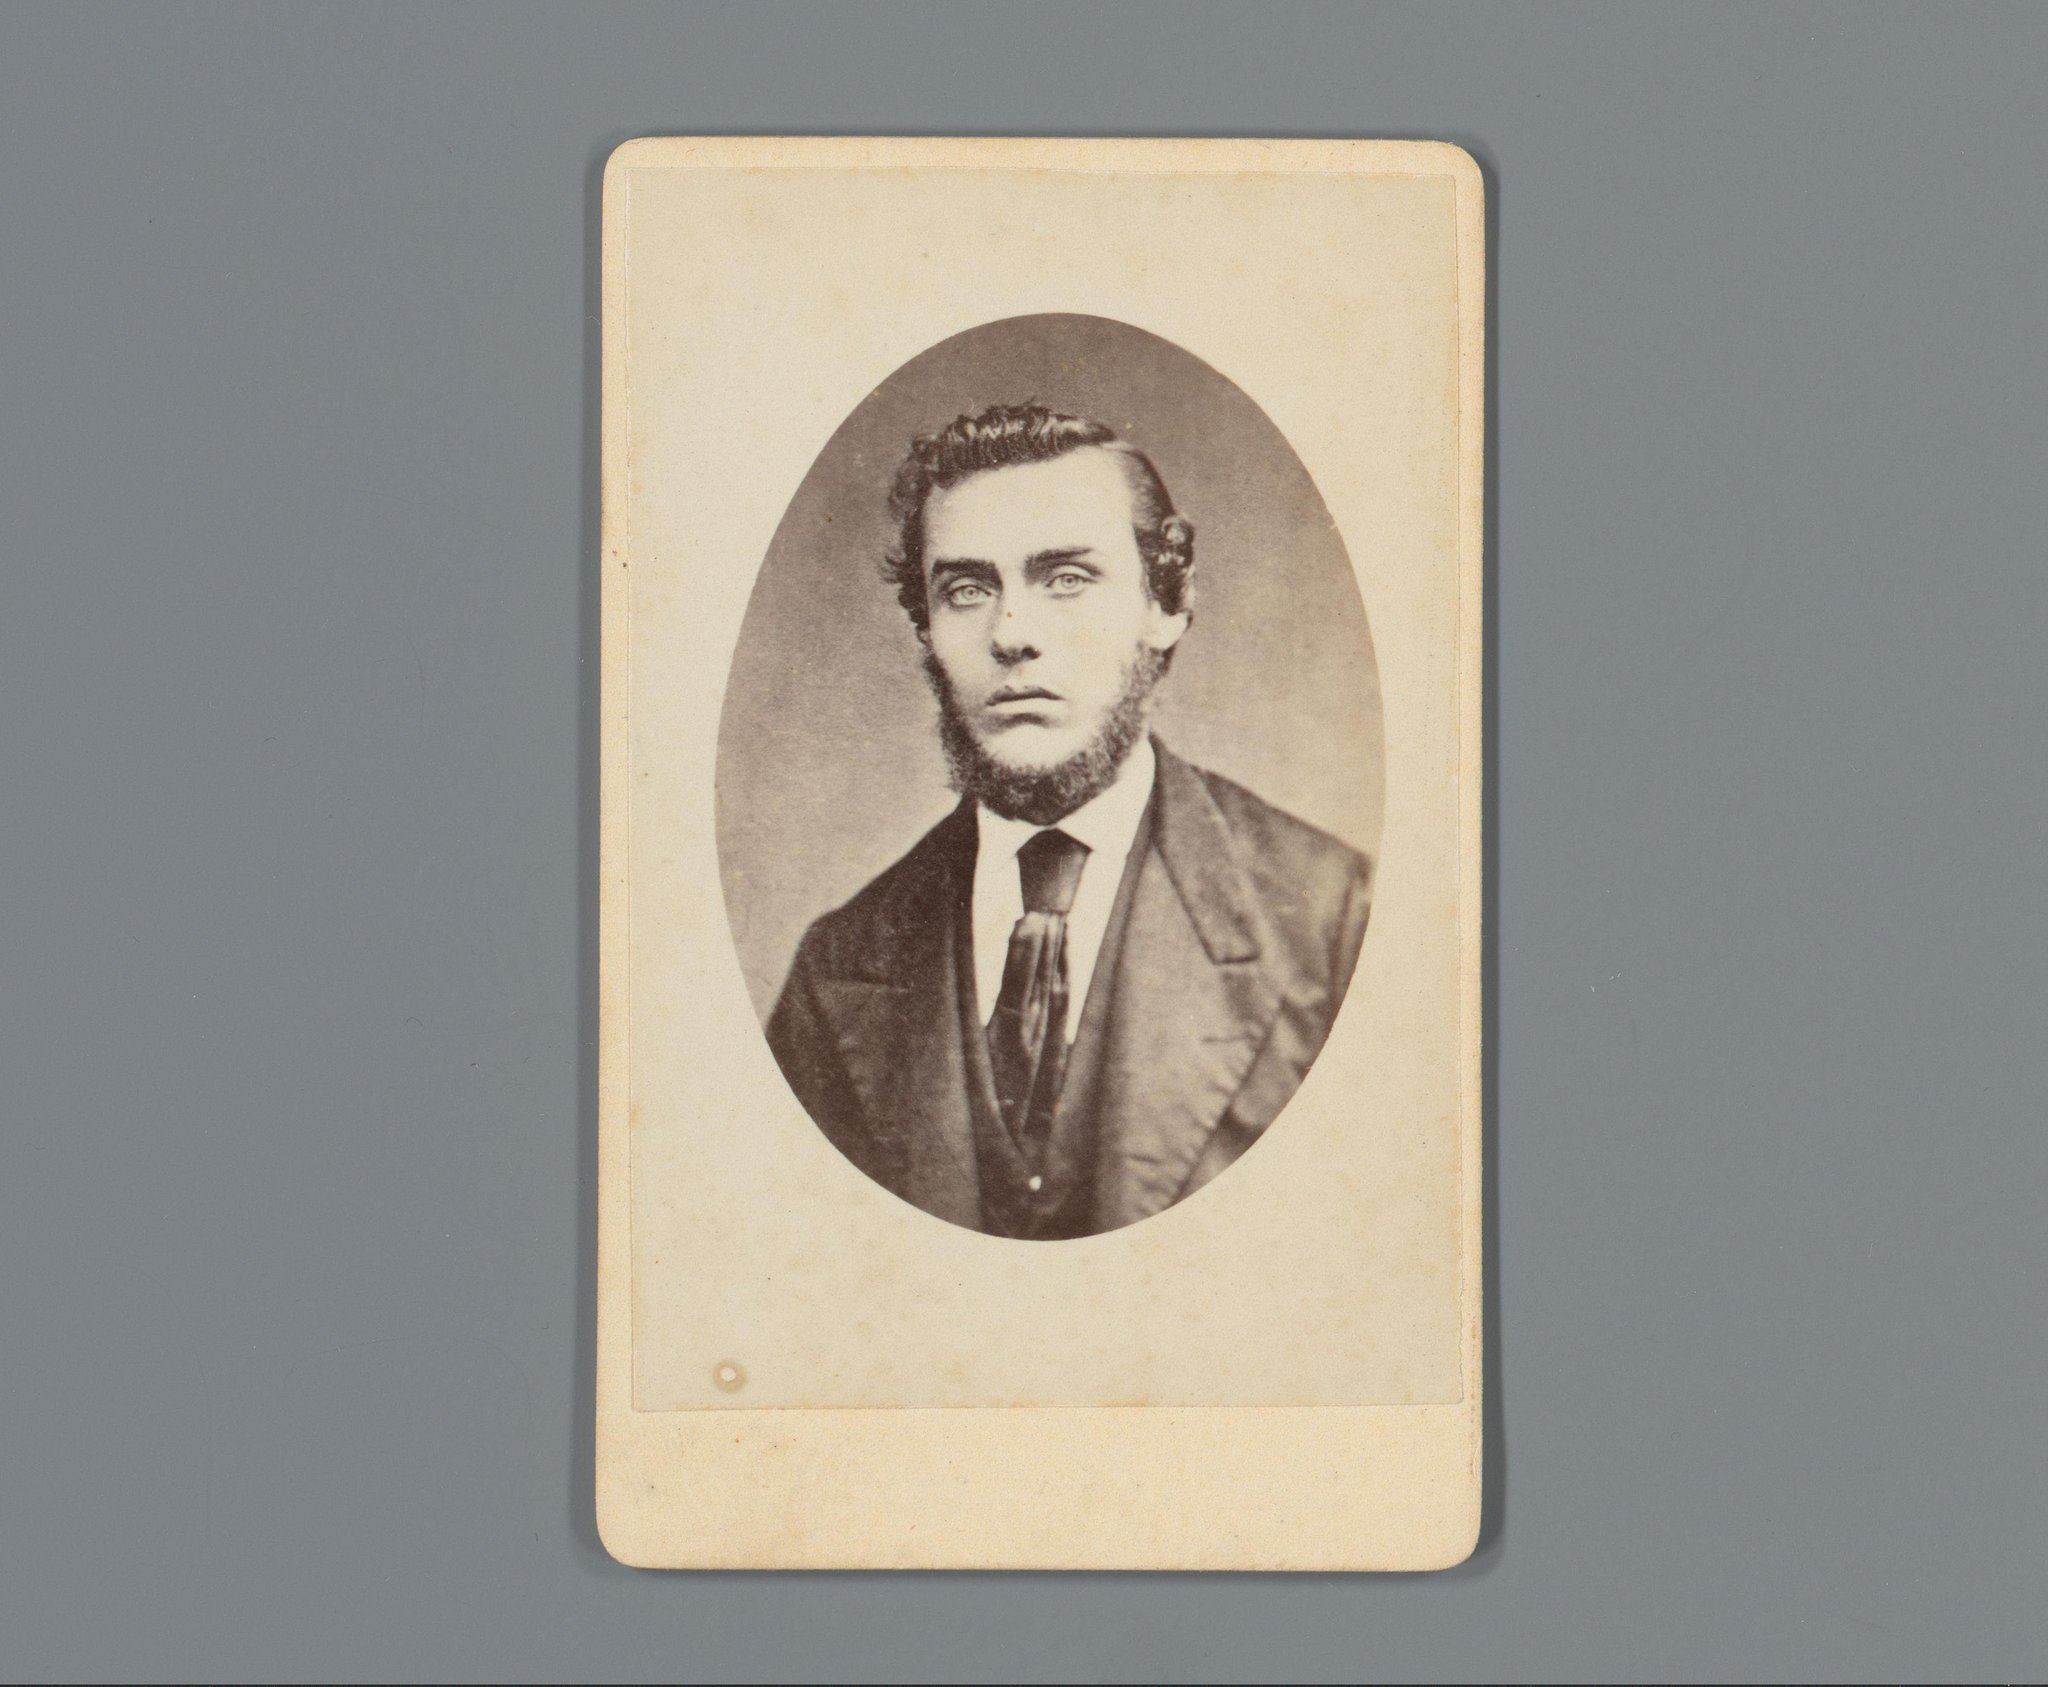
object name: photograph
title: Portret van een man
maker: willem gerhardus kuijer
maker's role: fotograaf, hoffotograaf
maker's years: 1834-1899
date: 1867-1880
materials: cardboard, photographic support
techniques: albumen print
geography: amsterdam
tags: anonymous historical person portrayed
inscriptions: inscription: ‘Bieger’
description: Portret van een man, ovaal buste en face, op de achterzijde aangeduid als 'Bieger' (?). Waarschijnlijk een lid of vriend van de familie Swellengrebel. Zie ook mogelijke pendant.